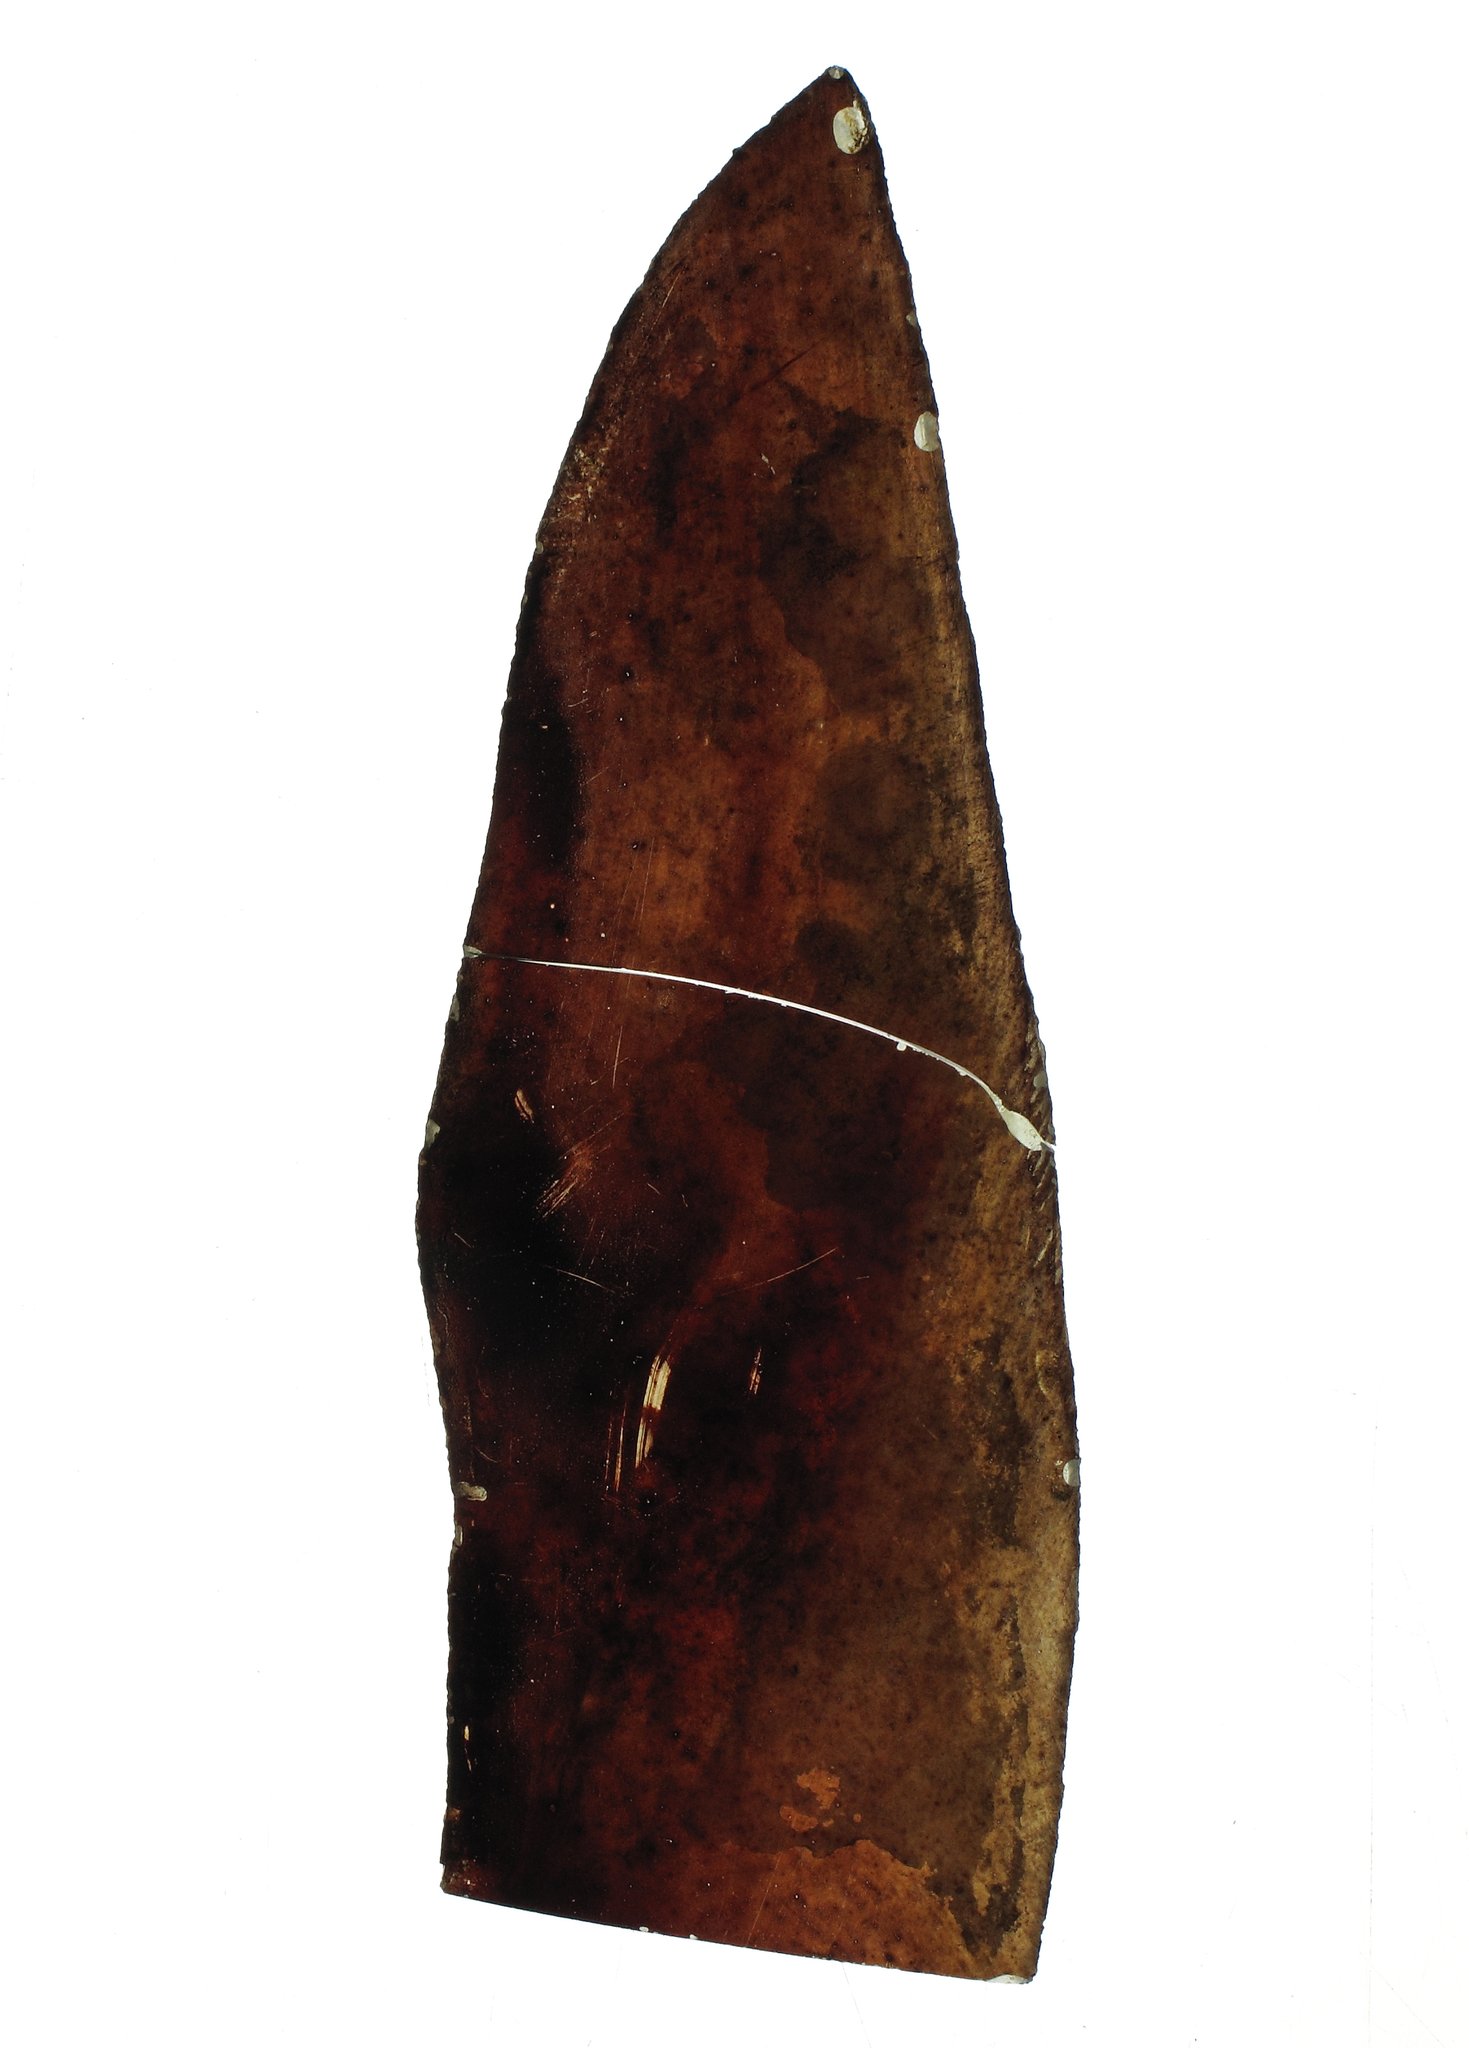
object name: fragment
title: Glass Fragment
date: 1101-1500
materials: glass, metal